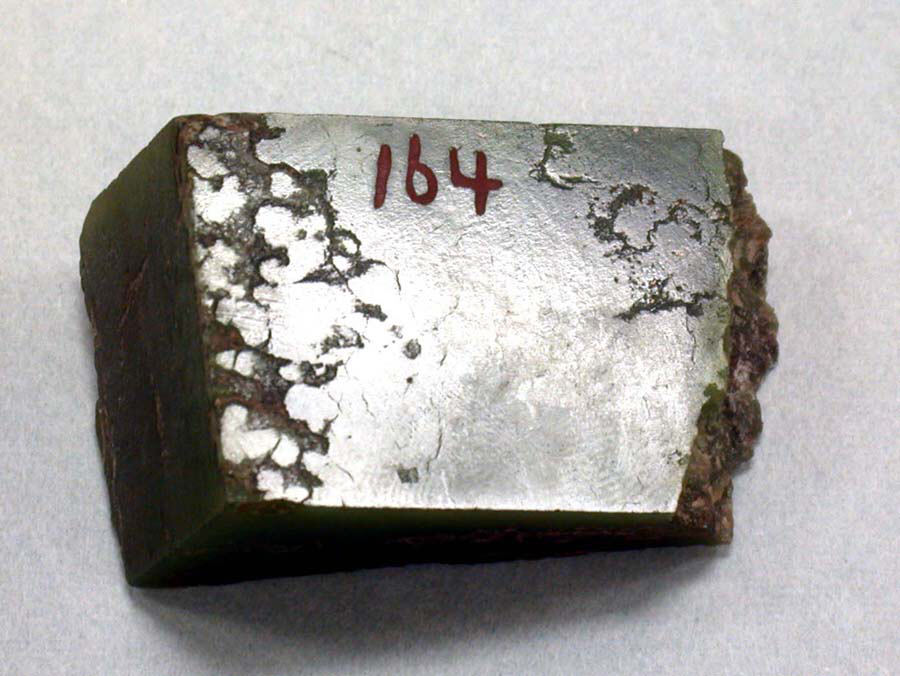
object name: fragment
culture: new zealander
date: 1902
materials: jade